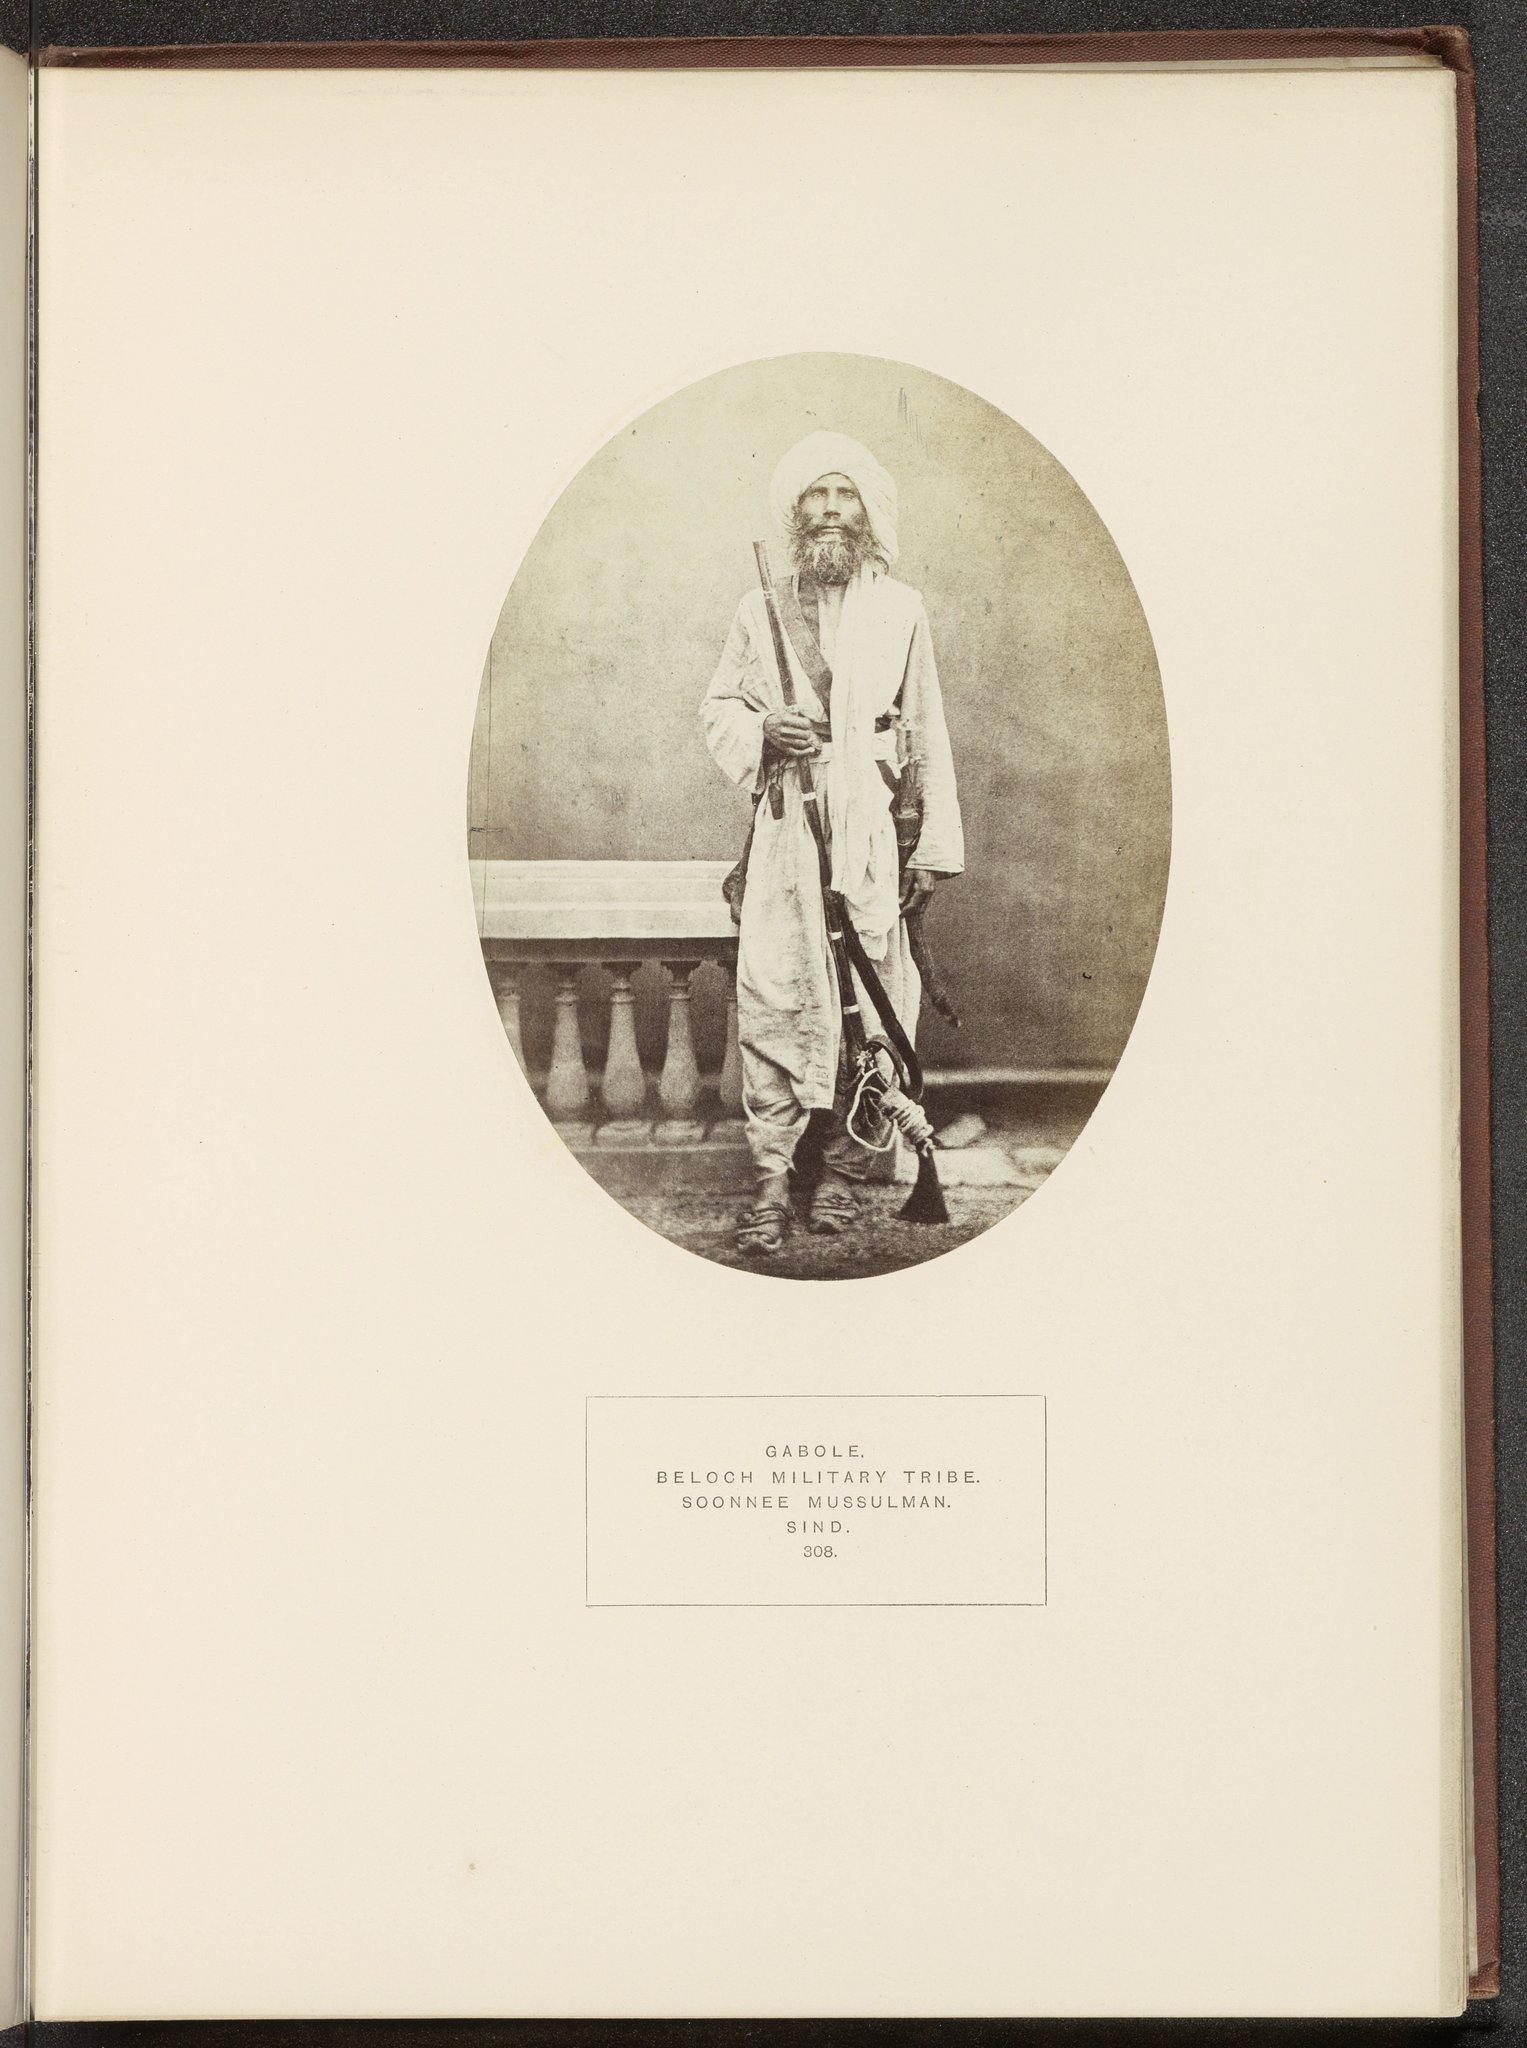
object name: photograph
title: Portrait of an unknown man with a rifle from the Gabol Baloch tribe in Sindh, Pakistan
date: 1862-1872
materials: photographic support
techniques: albumen print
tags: head-gear: turban, firearms: rifle, human races; peoples; nationalities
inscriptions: number: ‘308.’, inscription: ‘GABOLE./ BELOCH MILITARY TRIBE./ SOONNEE MUSSULMAN./ SIND.’